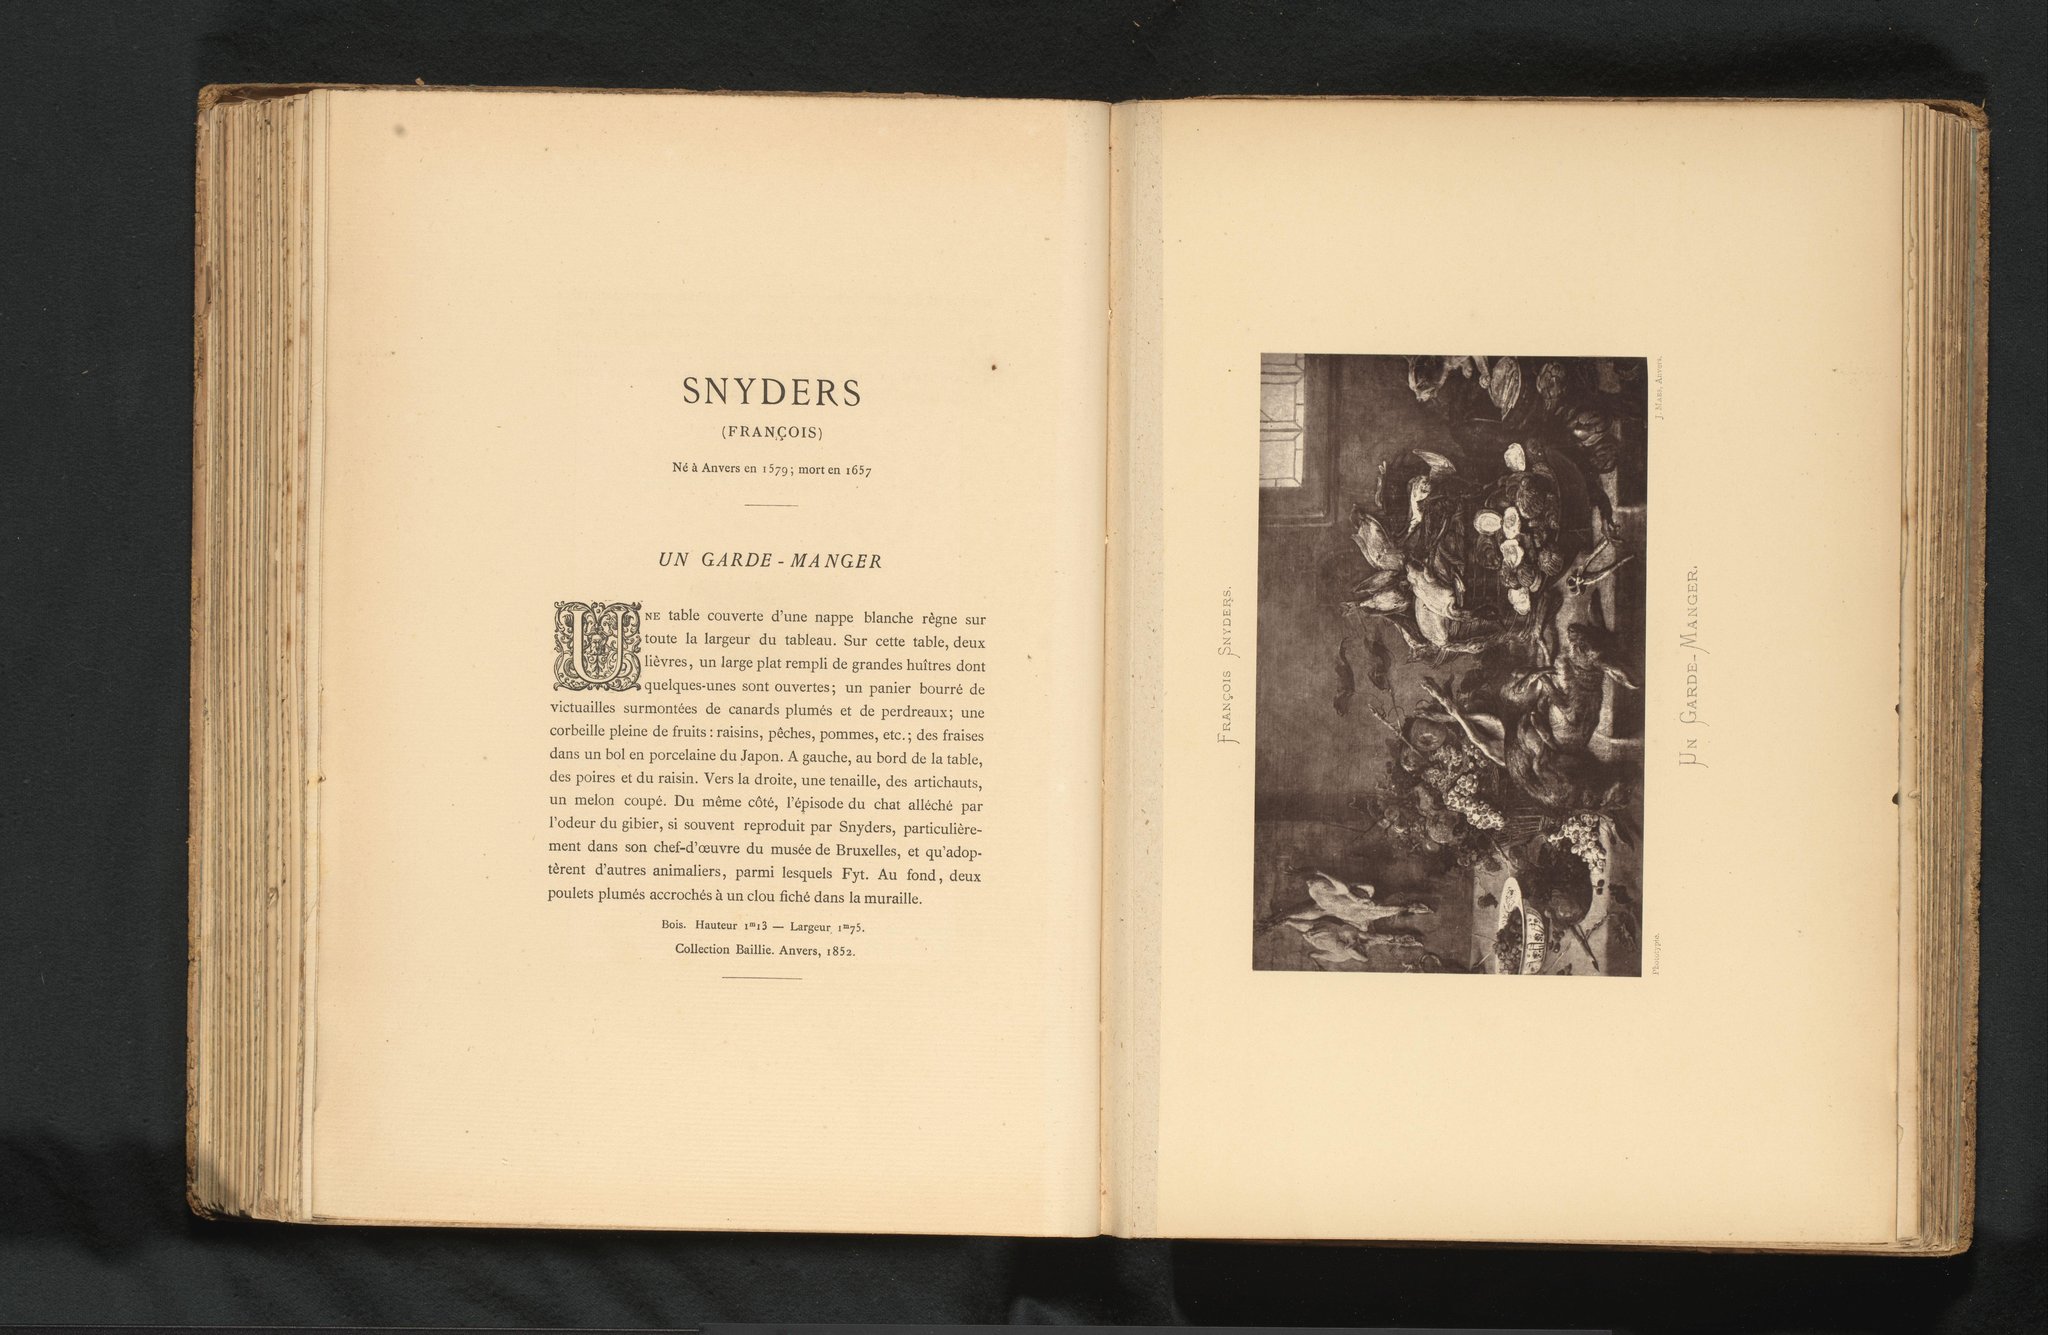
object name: reproduction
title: Reproductie van een schilderij van een stilleven met wild door Frans Snijders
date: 1873-1878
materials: paper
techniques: woodburytype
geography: antwerp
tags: rodents: hare, foodstuffs; still life of foodstuffs